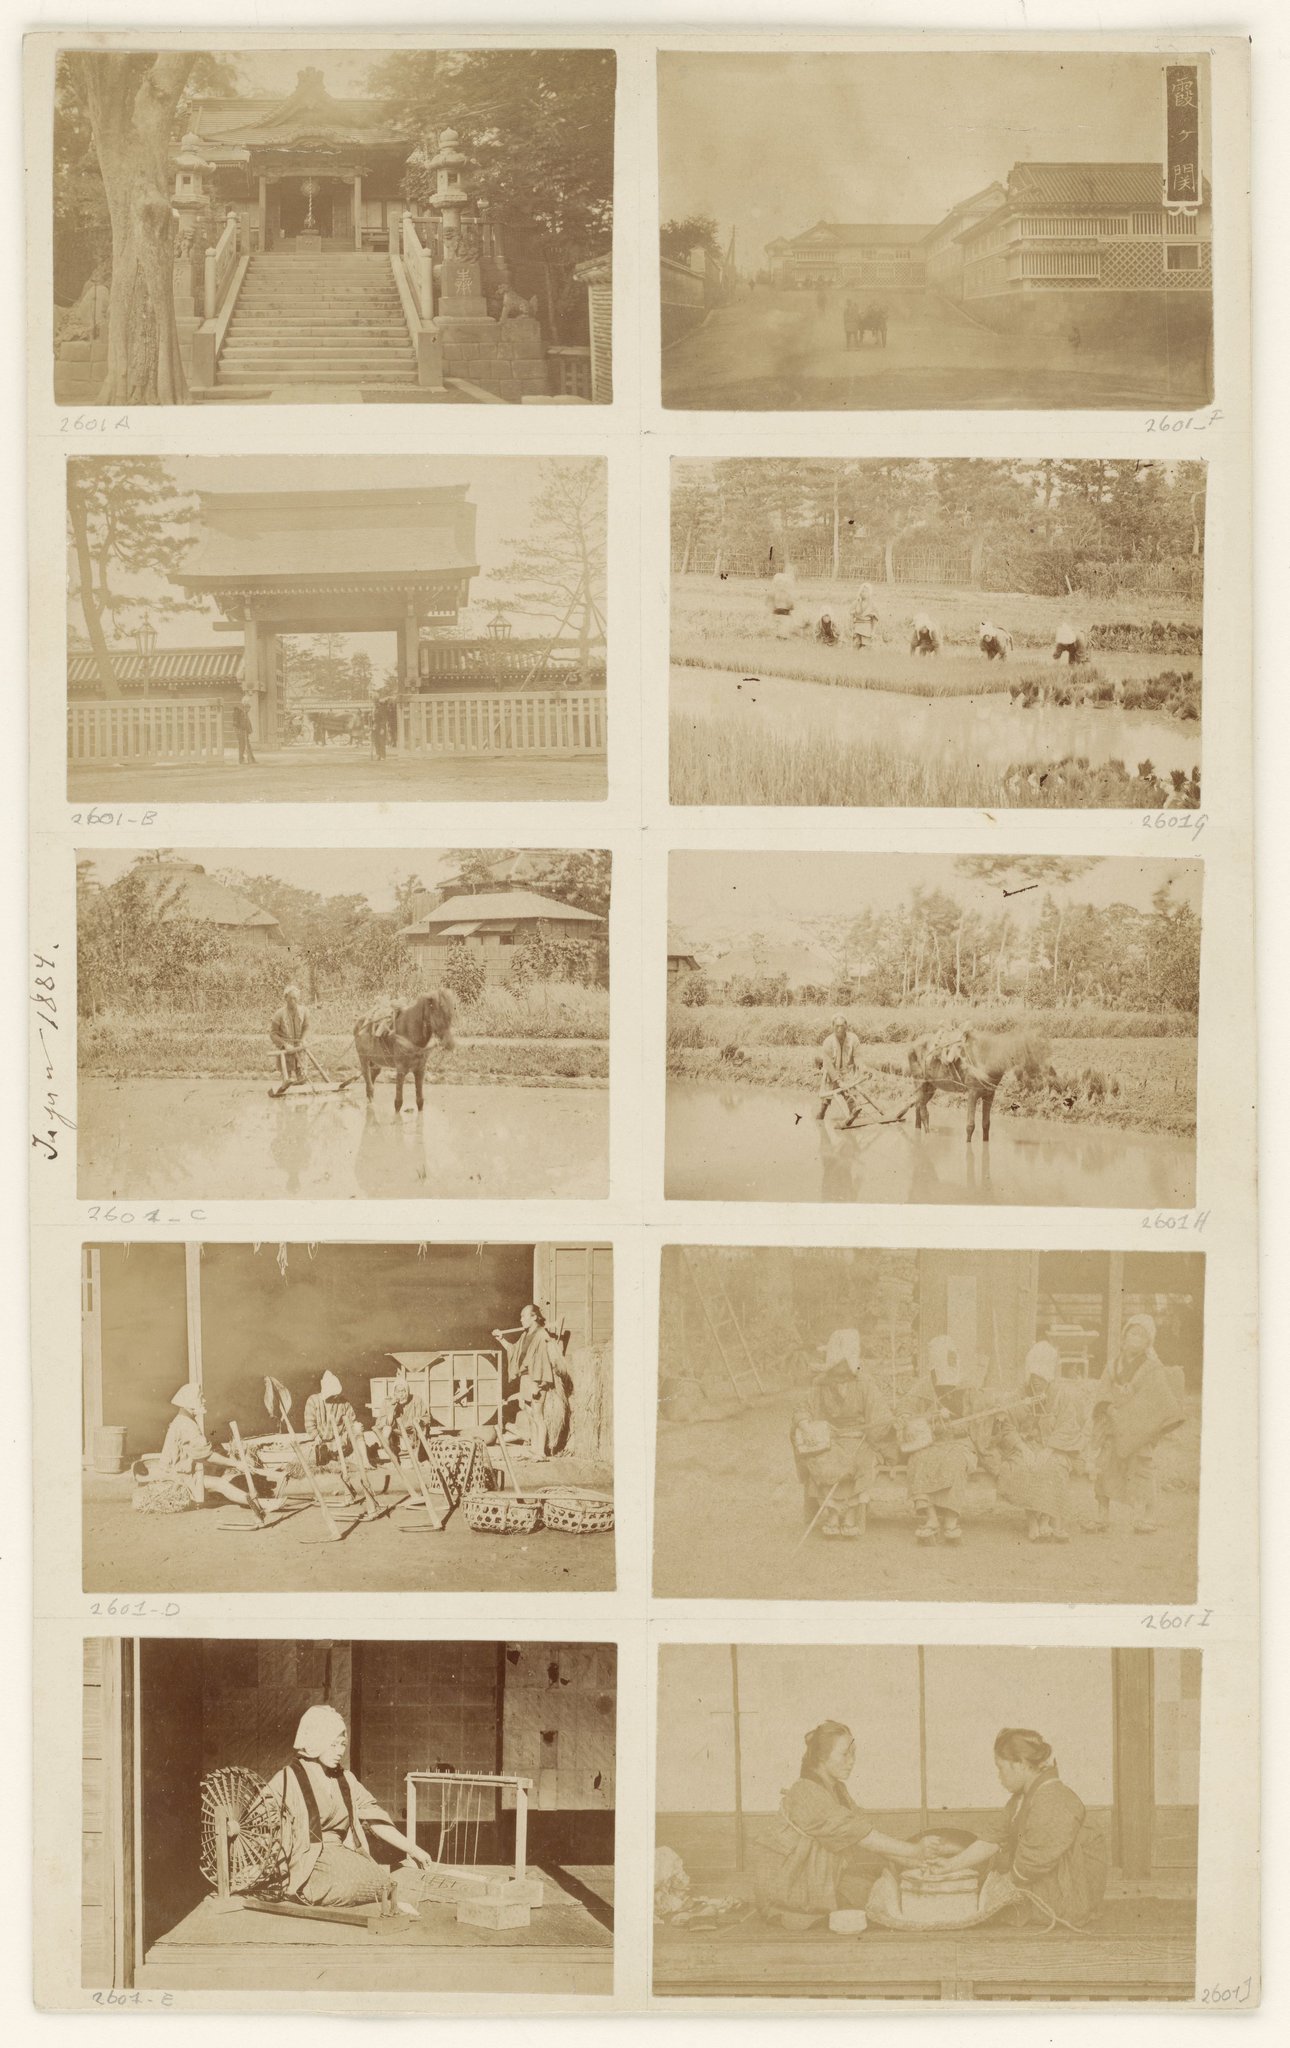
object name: photograph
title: Landarbeider op een rijstveld met paard en ploeg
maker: Anonymous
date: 1884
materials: cardboard, paper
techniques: albumen print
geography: japan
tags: sawahs, rice paddies, ploughing, japan